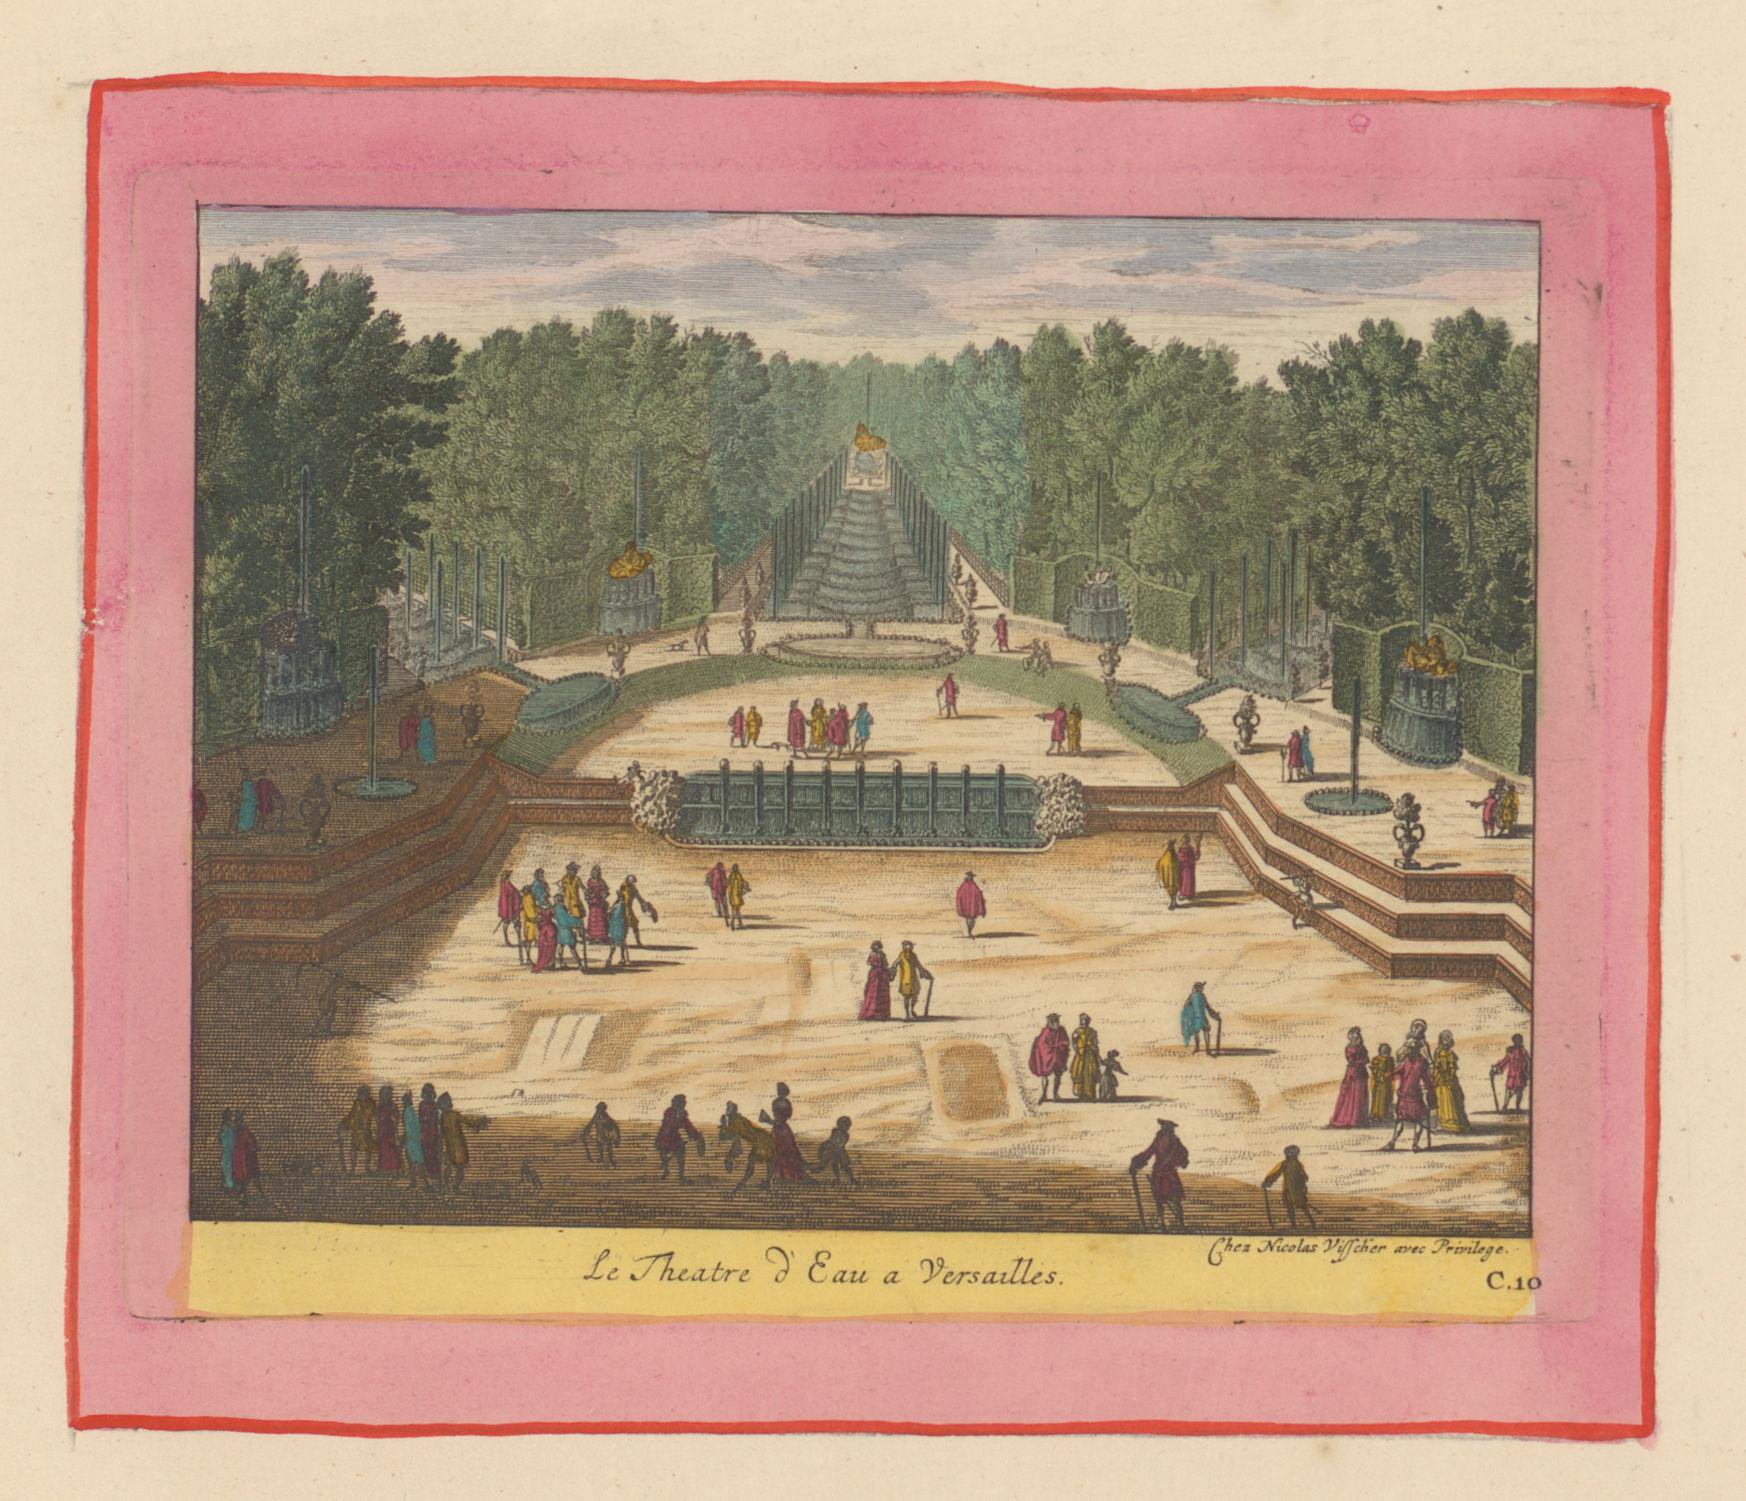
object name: album leaf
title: Veues de Versailles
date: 1686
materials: paper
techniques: etching, hand coloring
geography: amsterdam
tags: french or architectonic garden; formal garden, water-works in garden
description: De prent maakt deel uit van een serie bestaande uit 87 genummerde prenten (volgens Hollstein). De serie is opgedeeld in de delen A t/m F.